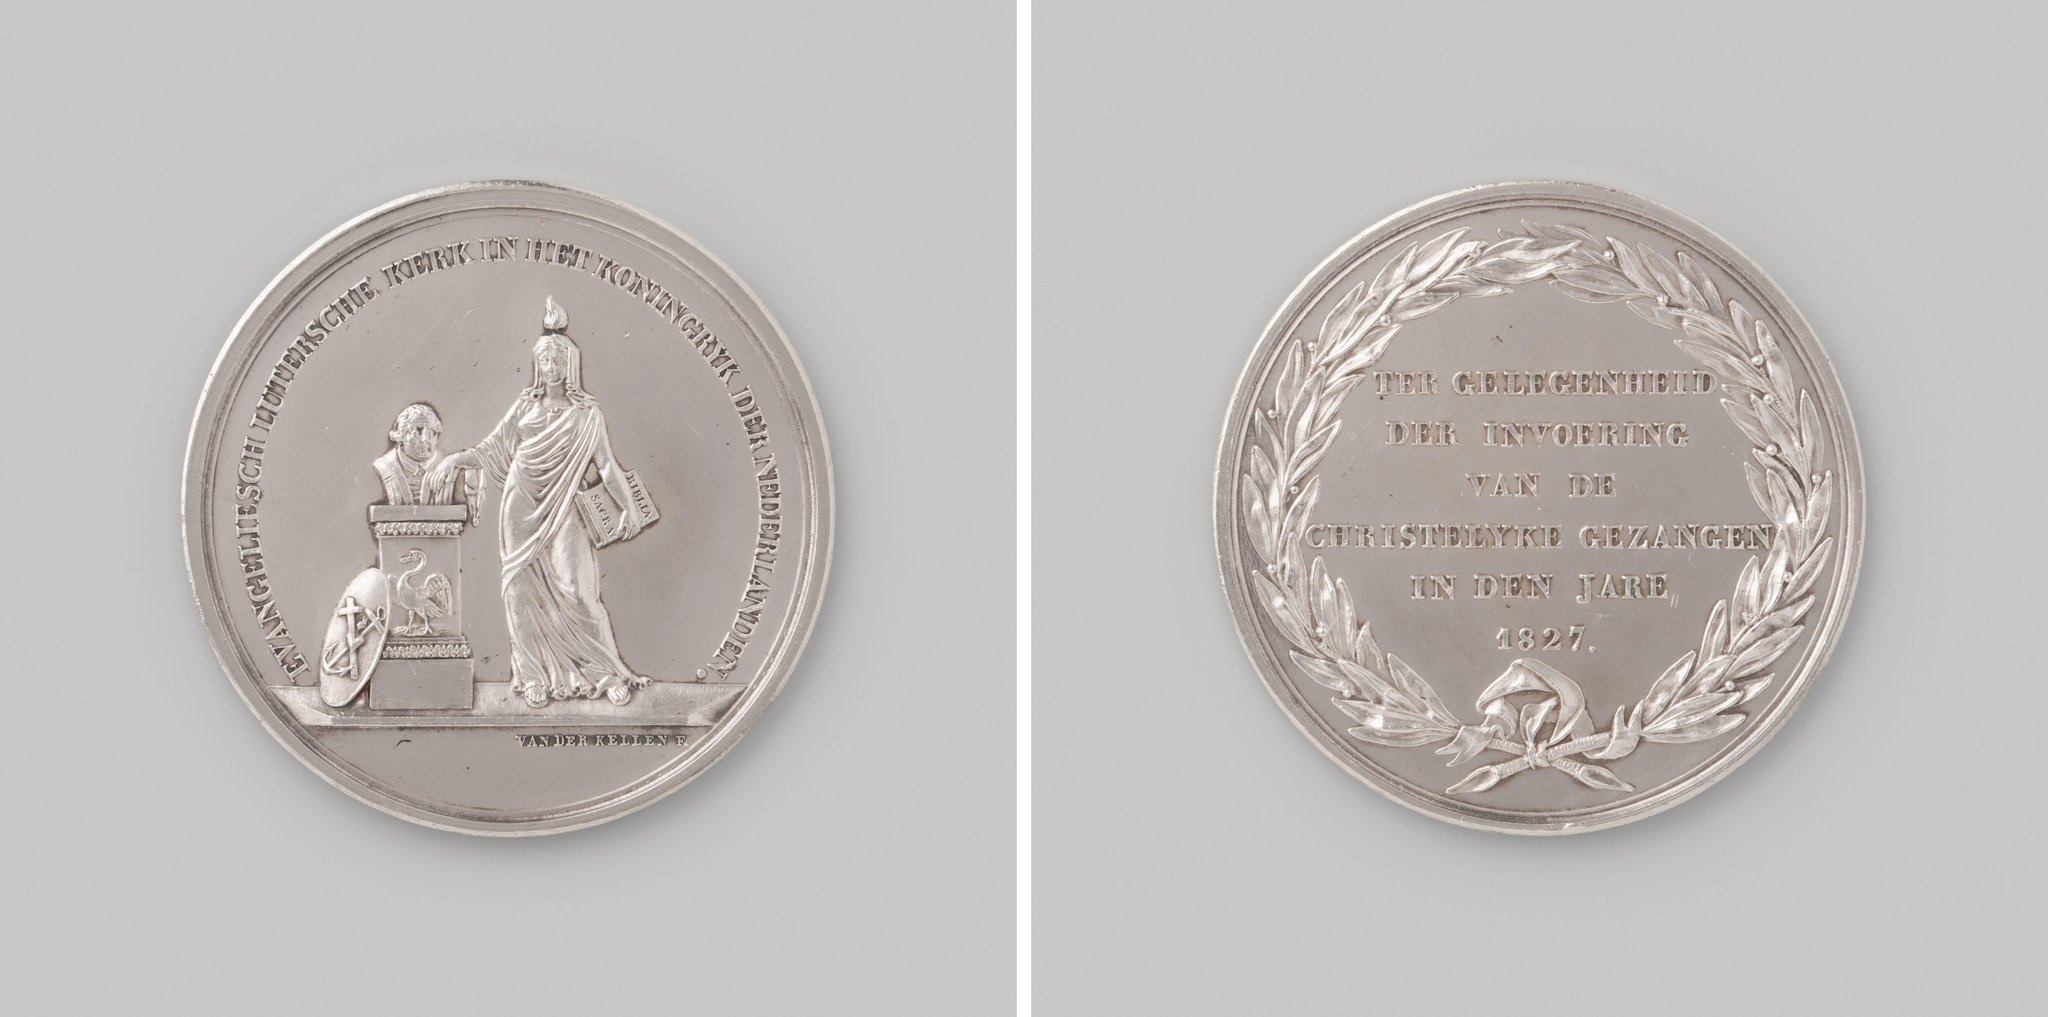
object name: history medal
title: Invoering van nieuwe christelijke gezangen door de Luthersche gemeenten in Nederland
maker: david van der kellen (1804-1879)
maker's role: die cutter, draughtsman, print maker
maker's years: 1804-1879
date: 1827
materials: silver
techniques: striking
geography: utrecht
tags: netherlands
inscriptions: signature: ‘VAN DER KELLEN F.’, inscription: ‘TER GELEGENHEID/ DER INVOERING/ VAN DE/ CHRISTELYKE GEZANGEN/ IN DEN JARE/ 1827’, circumscription: ‘EVANGELIESCH LUTERSCHE KERK IN HET KONINGRYK DER NEDERLANDEN.’